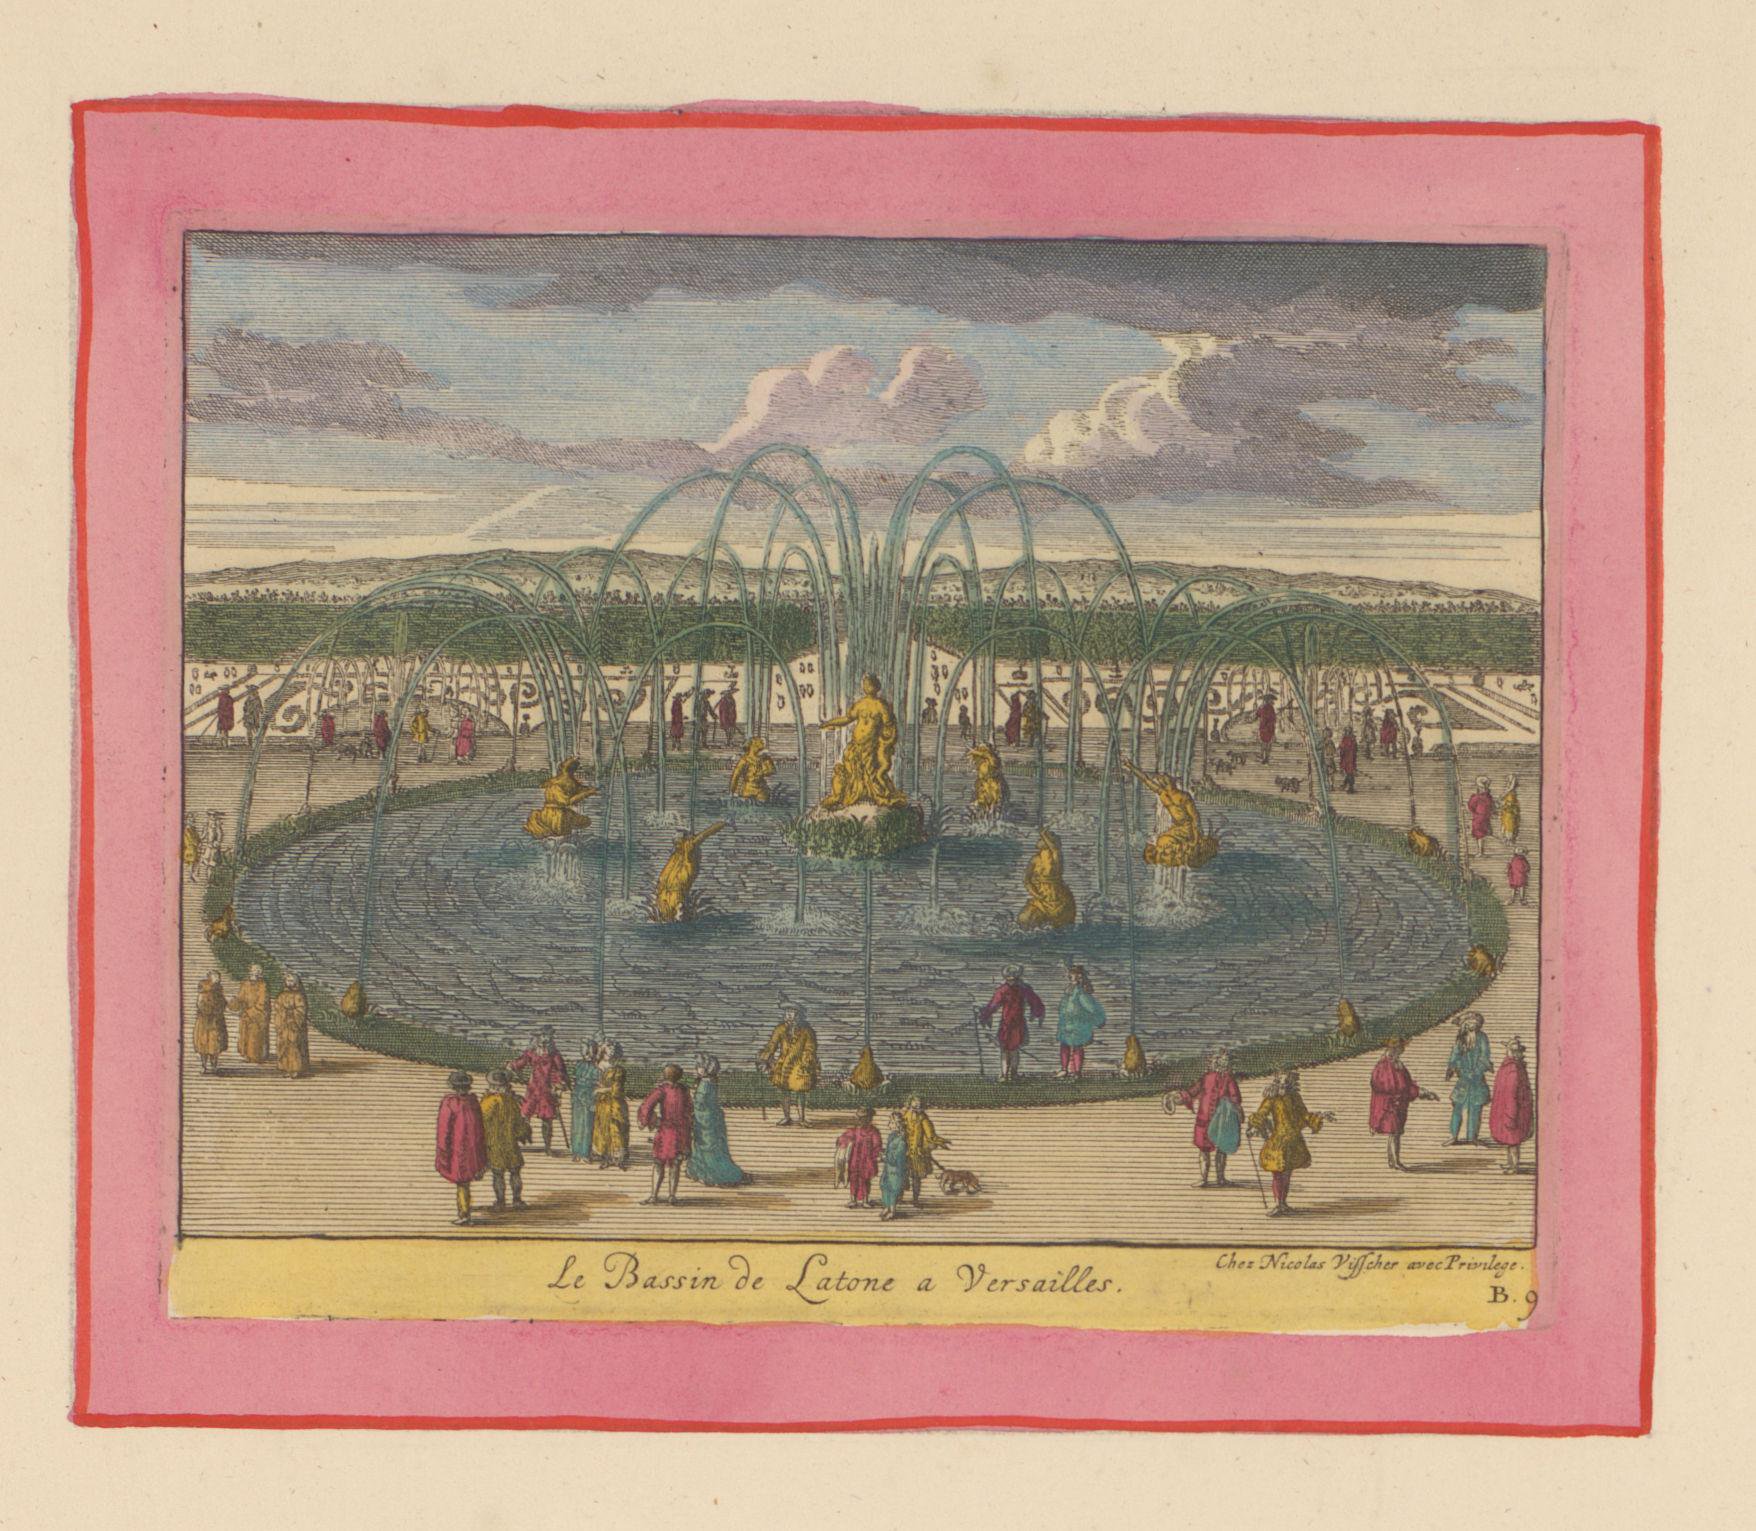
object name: album leaf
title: Bassin de Latone in de tuinen van Versailles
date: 1686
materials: paper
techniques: etching, hand coloring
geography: the hague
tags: garden fountain, french or architectonic garden; formal garden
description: De prent maakt deel uit van een serie bestaande uit 87 genummerde prenten (volgens Hollstein). De serie is opgedeeld in de delen A t/m F.